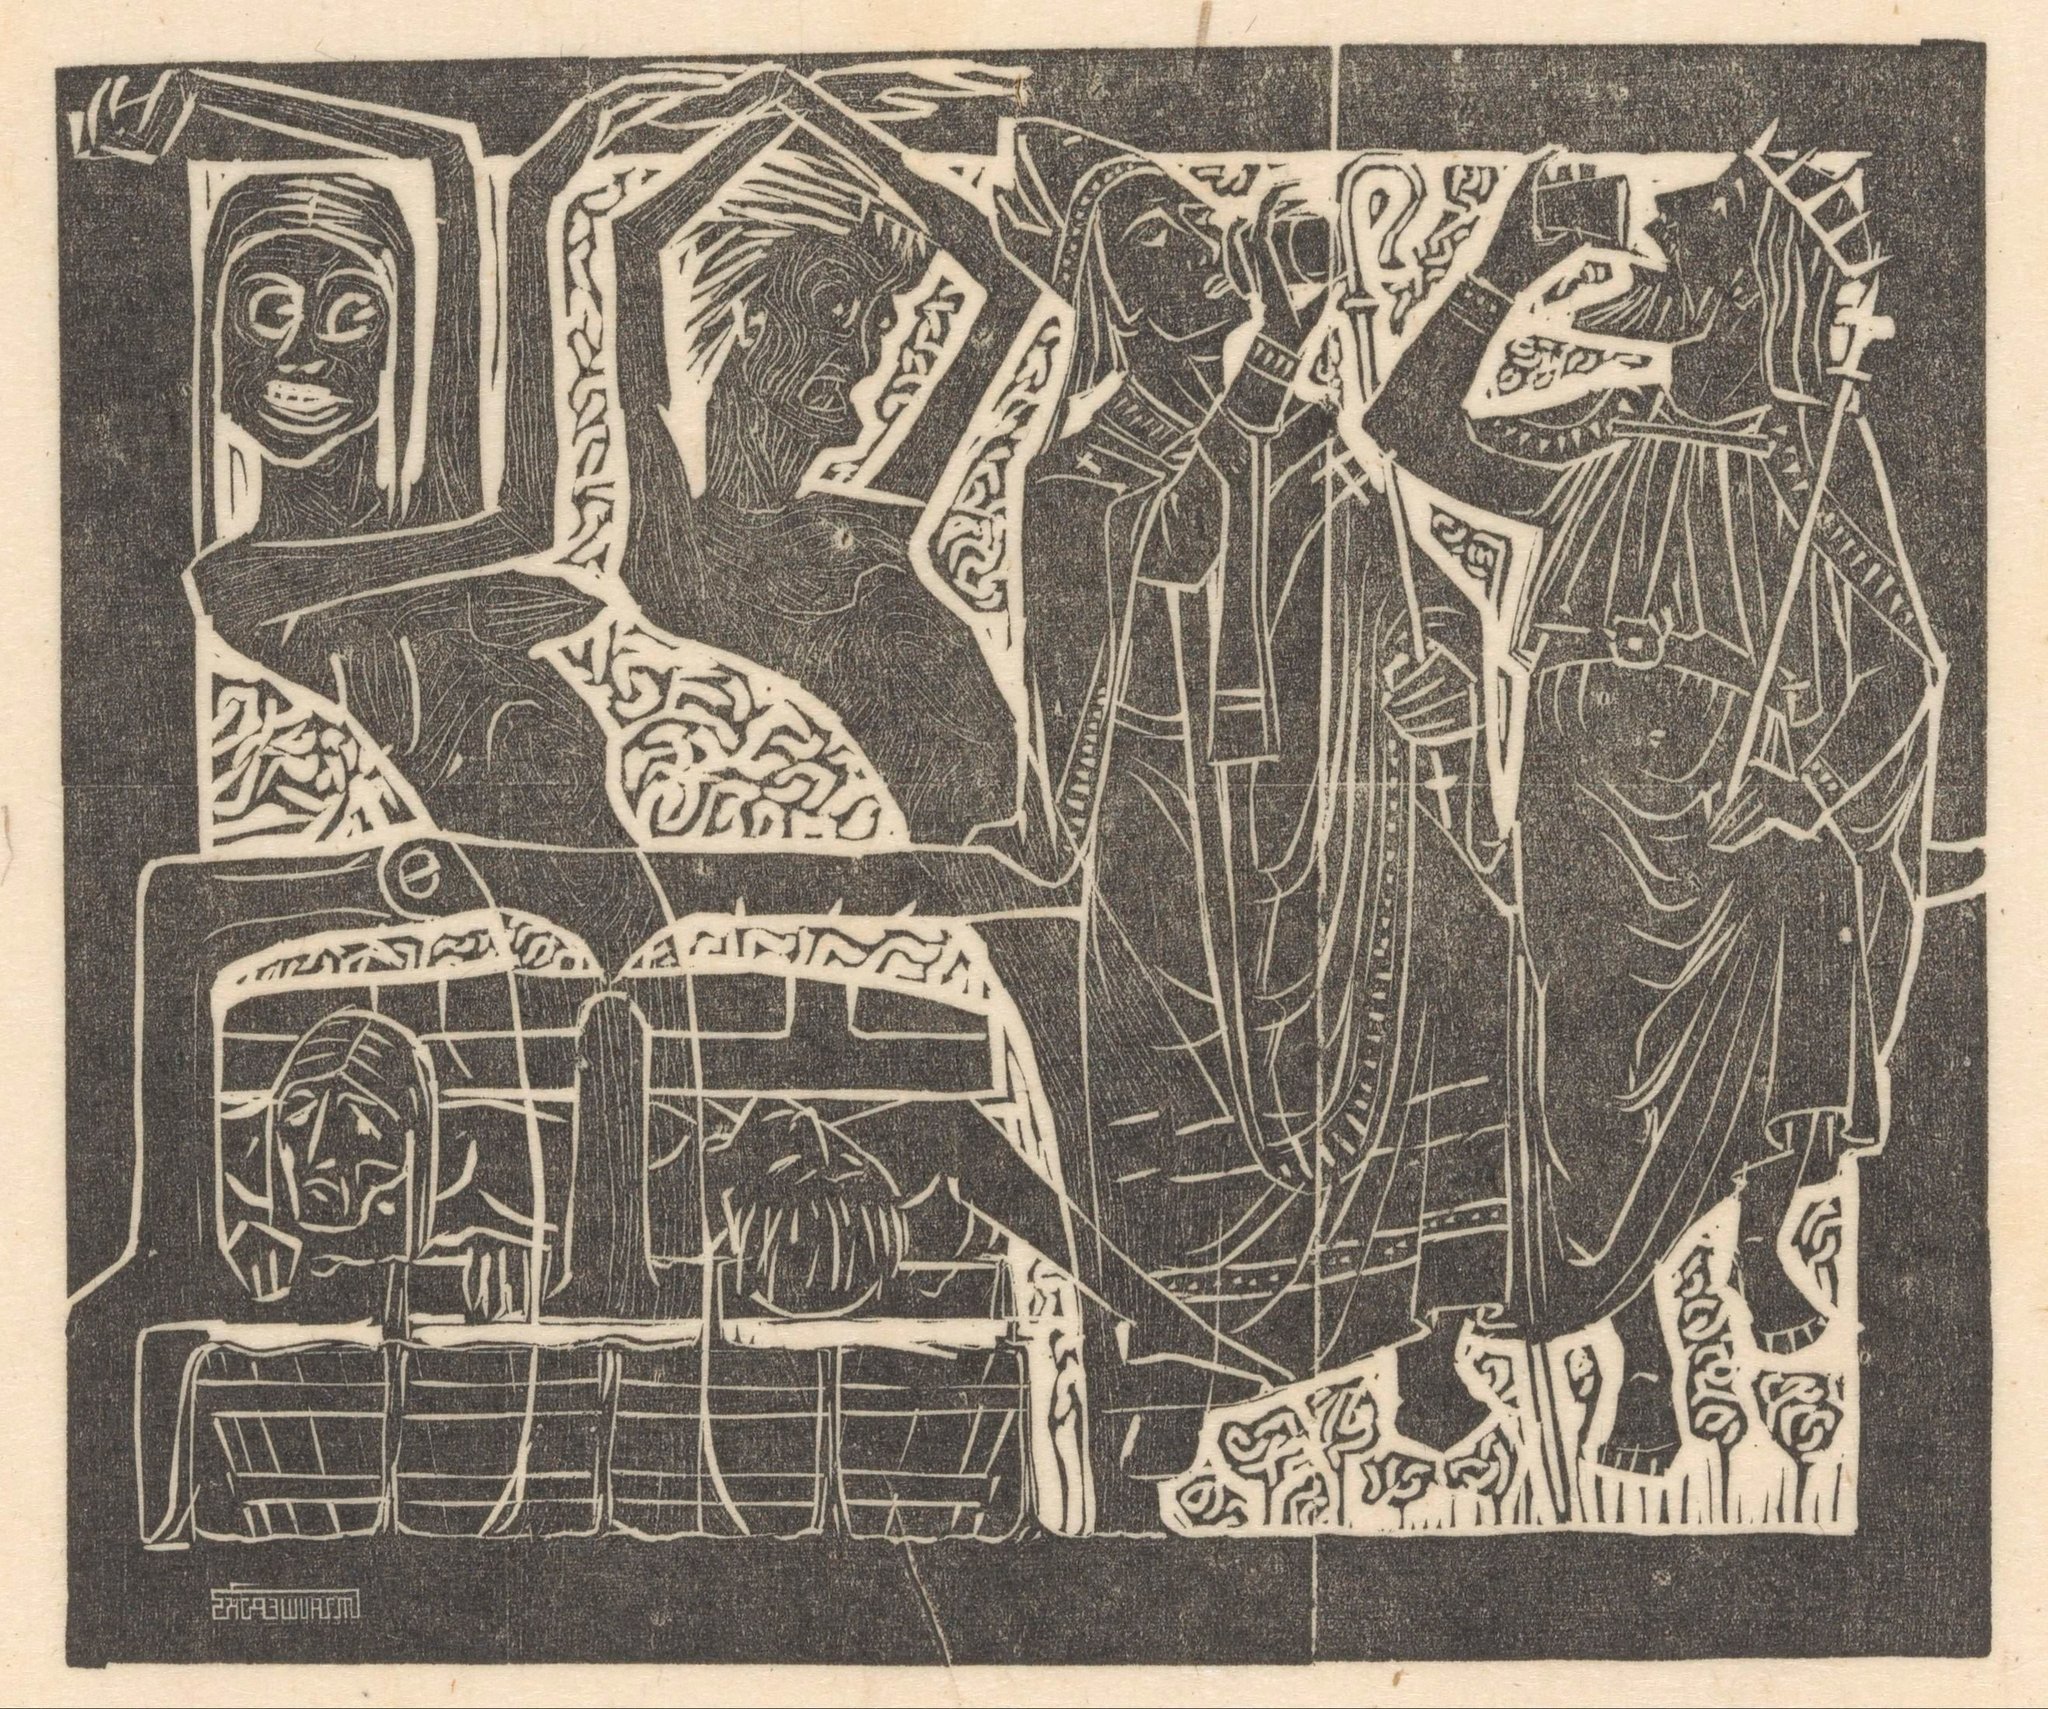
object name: illustration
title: Wijnpers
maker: mathieu lauweriks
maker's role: designer, draughtsman, print maker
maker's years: 1864-1932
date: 1894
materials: paper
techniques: woodcut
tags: personifications of countries, nations, states, districts, etc., wine-press, the church personified, 'ecclesia', usually with chalice and banner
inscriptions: collector's mark: Lugt 2228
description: Links een wijnpers waarmee het bloed van twee mensen wordt uitgeperst. Bij de pers twee dansende naakte figuren. Rechts staan een bisschop en een koning, als personificaties van de Kerk en de Staat, te drinken.